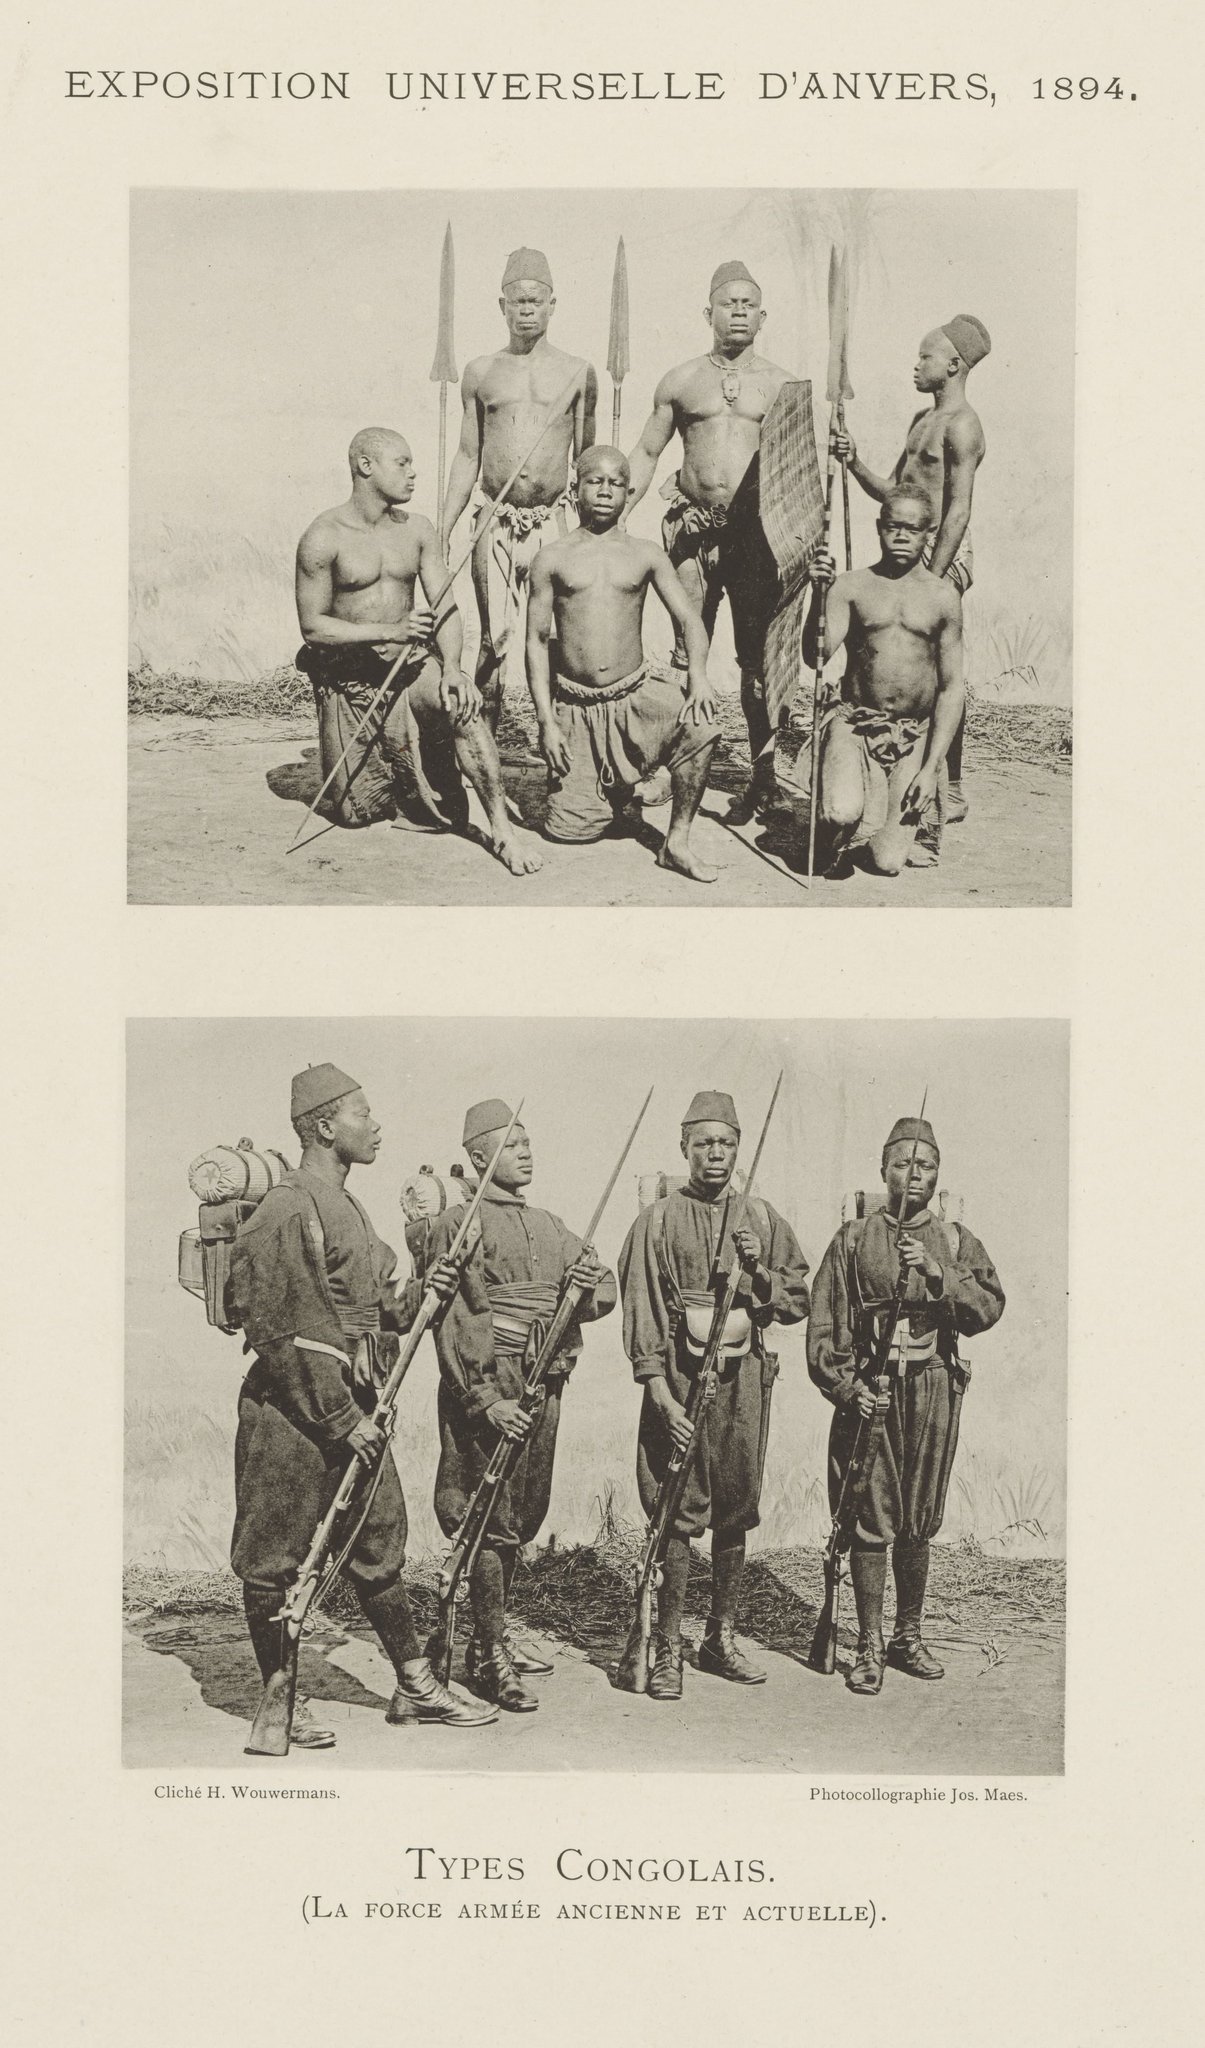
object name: photograph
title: Types Congolais (La Force Armee Ancienne et Actuelle, Exposition Universelle D'Anvers, 1894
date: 1894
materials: cardboard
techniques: photograph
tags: antwerp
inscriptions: signature: ‘Cliche H. Wouwermans; Photocollographie Jos. Maes.’, title: ‘Exposition Universelle DÁnvers, 1894; Types Congolais. (La Force Armee et Actuelle)’